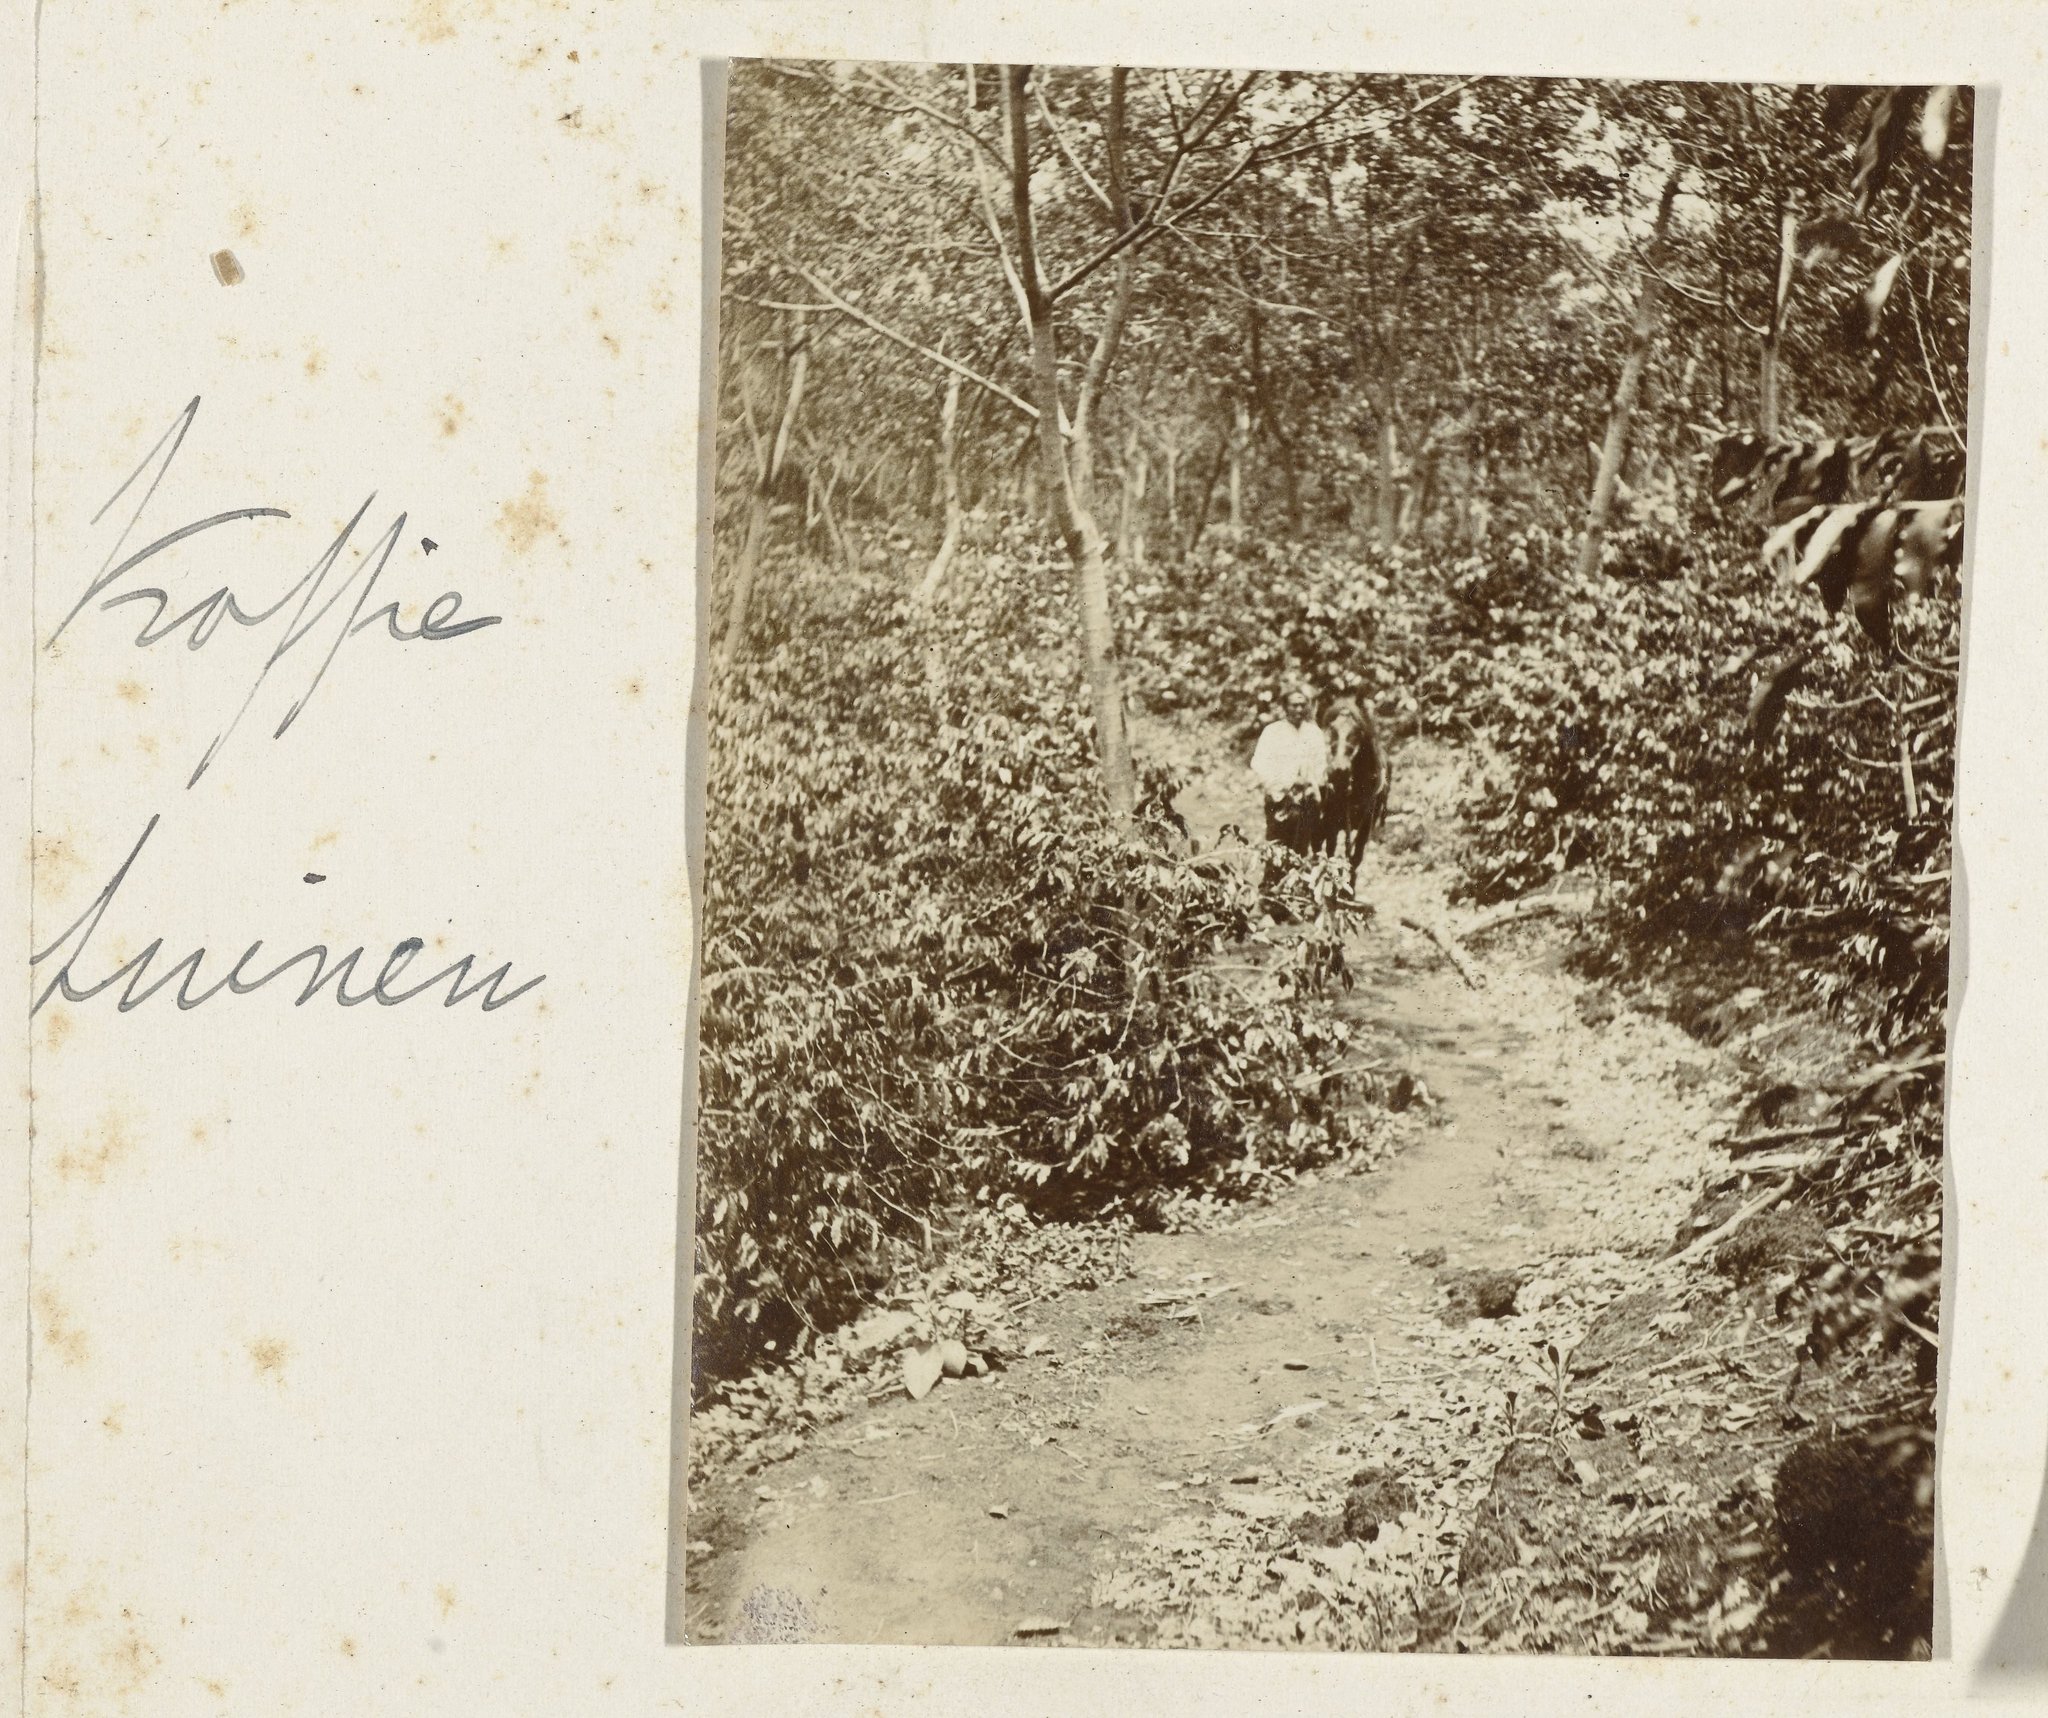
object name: photograph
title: Koffietuinen van Silo Sanen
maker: Anonymous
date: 1890-1910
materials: cardboard, paper, photographic support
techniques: gelatin silver print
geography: indonesia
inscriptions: caption: ‘Koffietuinen van Silo Sanen’